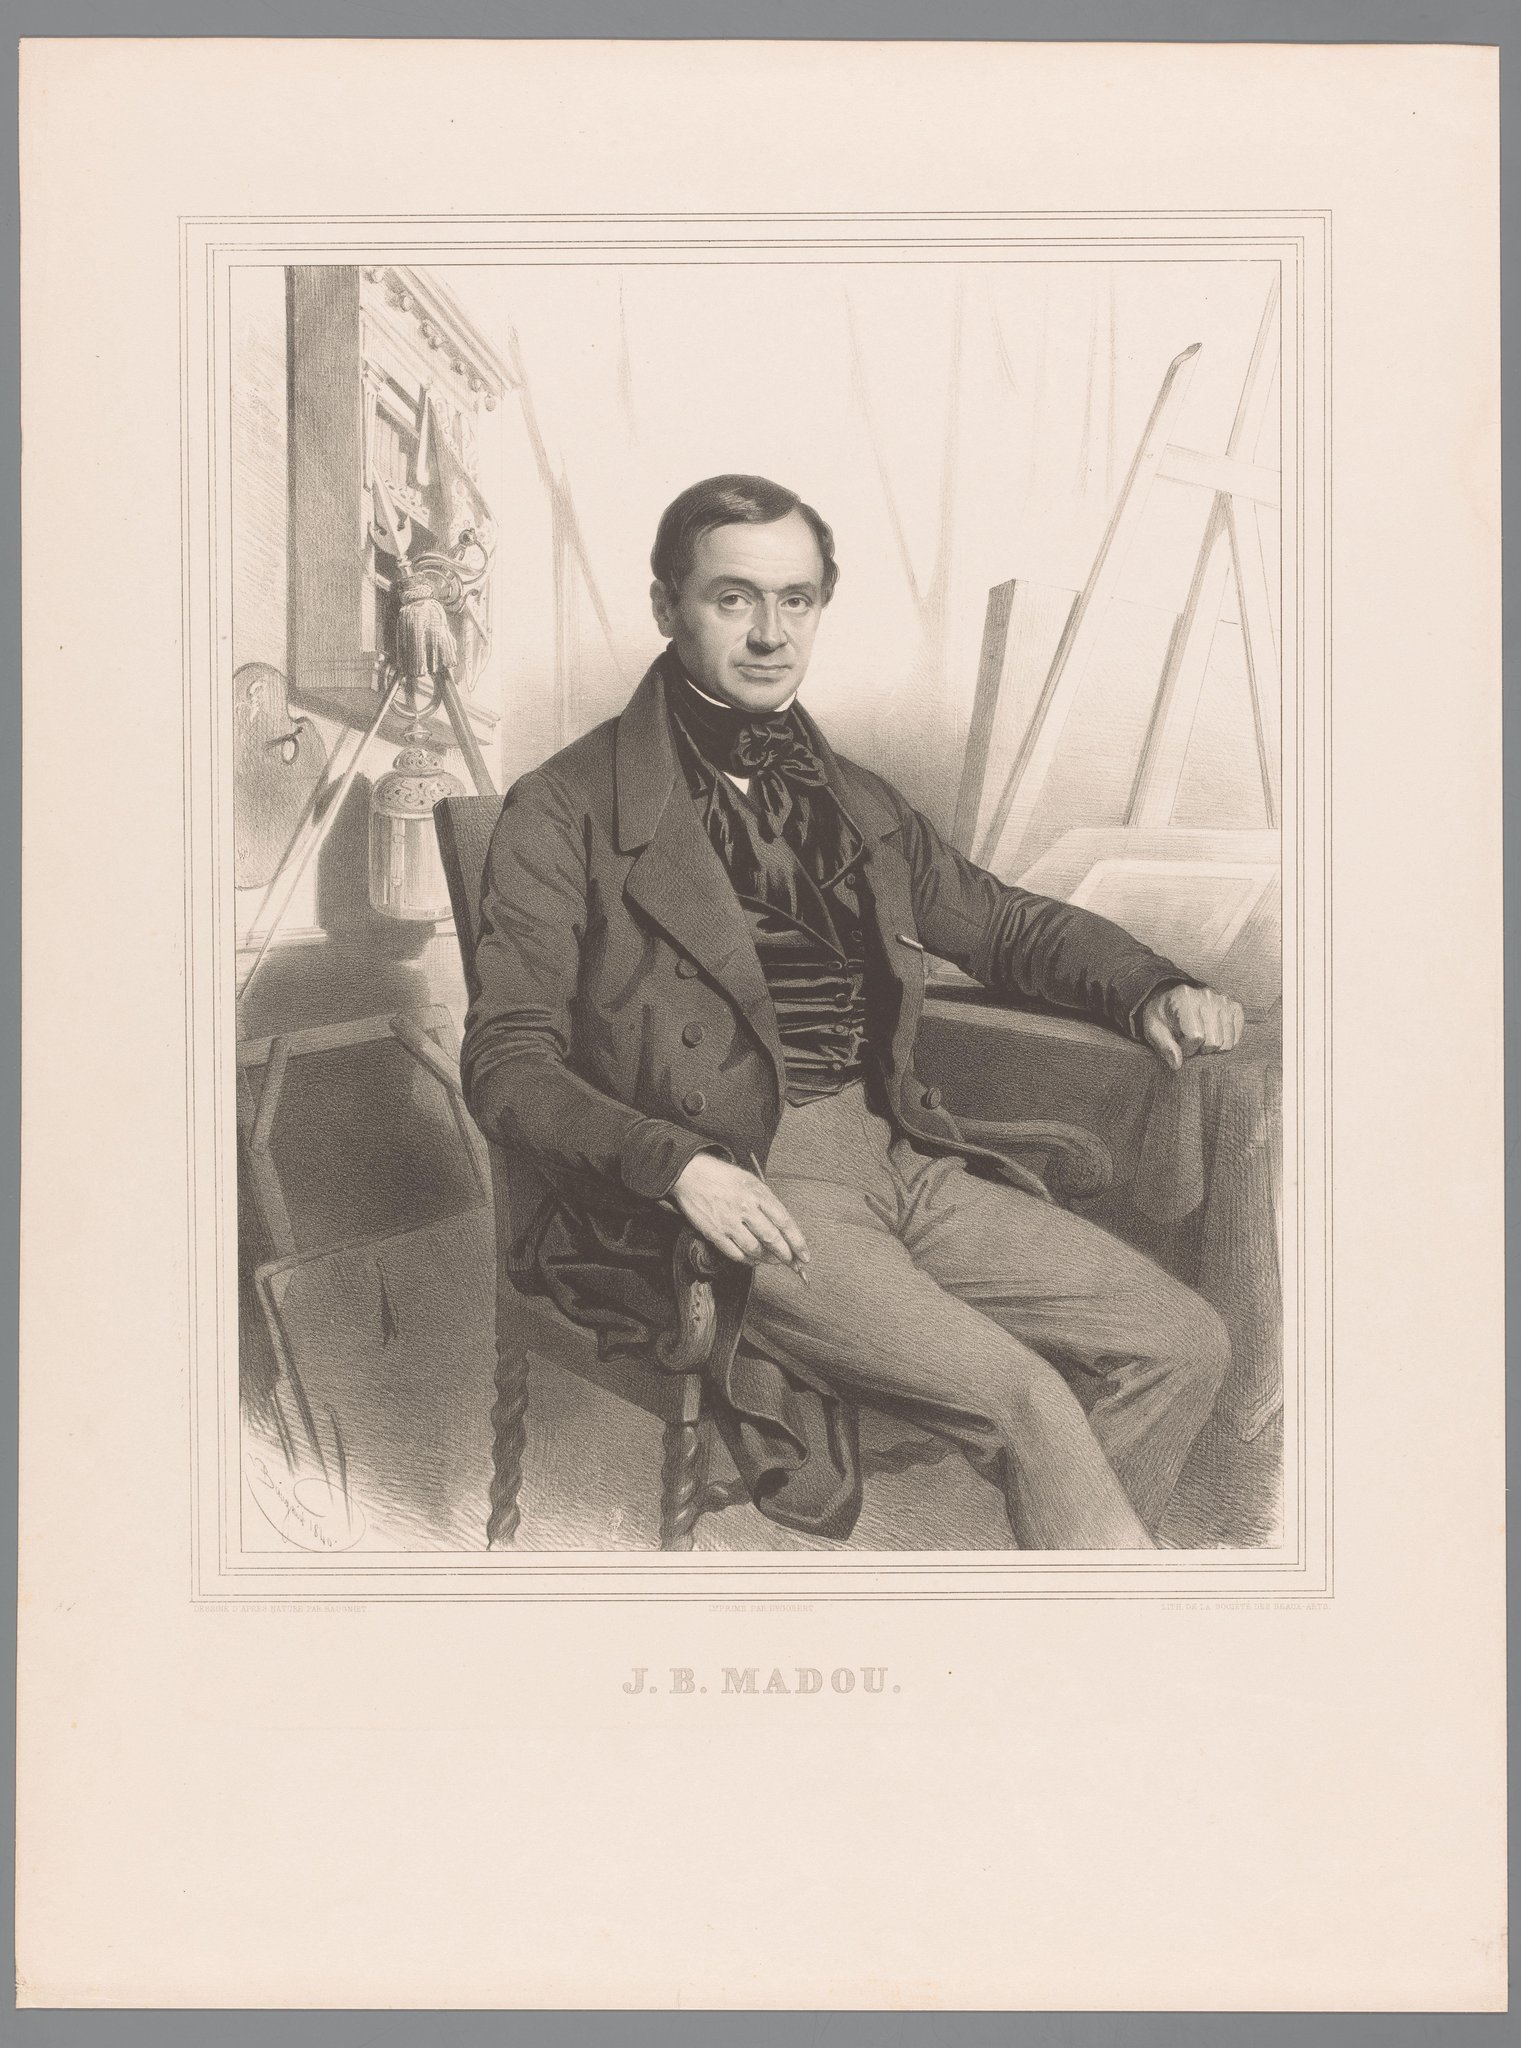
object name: print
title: Portret van Jean Baptiste Madou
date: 1840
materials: paper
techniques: lithograph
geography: brussels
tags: brussels, painter, draughtsman, jean baptiste madou, adult man, historical persons, tools, implements of painter, portrait, self-portrait of artist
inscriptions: collector's mark: Lugt 2228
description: Prent verschenen in: Baugniet, Charles. Les artistes contemporains: portraits lithographiés d'après nature, accompagnés de notices sur la vie et les ouvrages de chacun d'eux. Brussel: De Wasme-Pletinckx, [1836-1840].